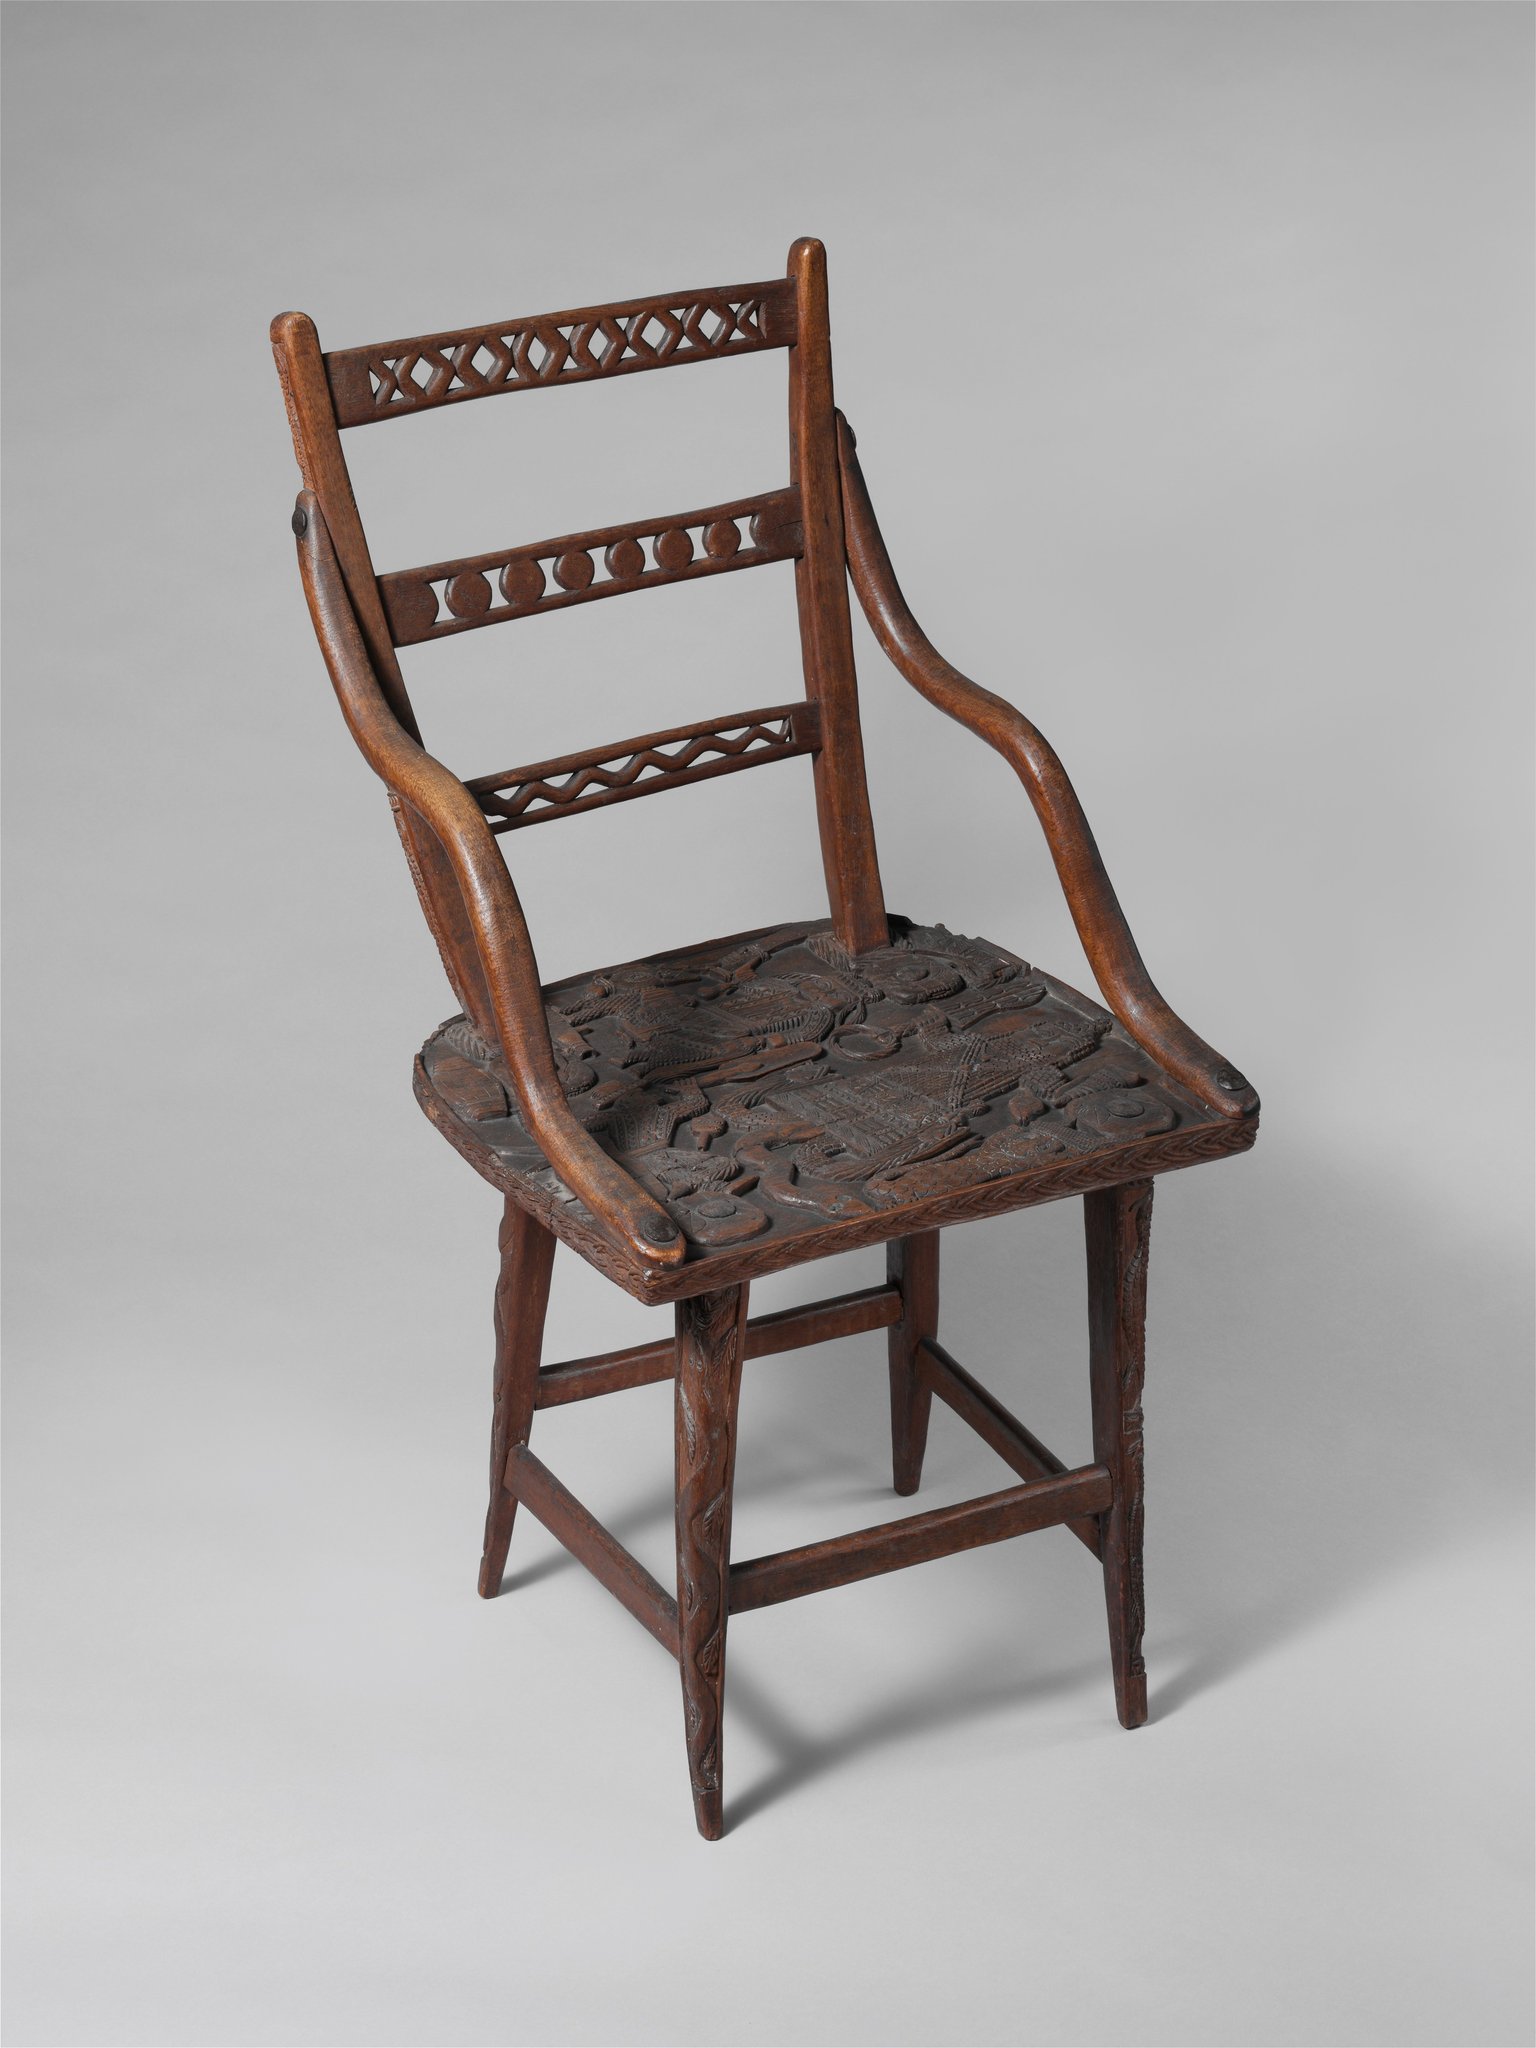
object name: chair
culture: edo period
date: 1801-1900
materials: glass, metal, wood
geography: nigeria